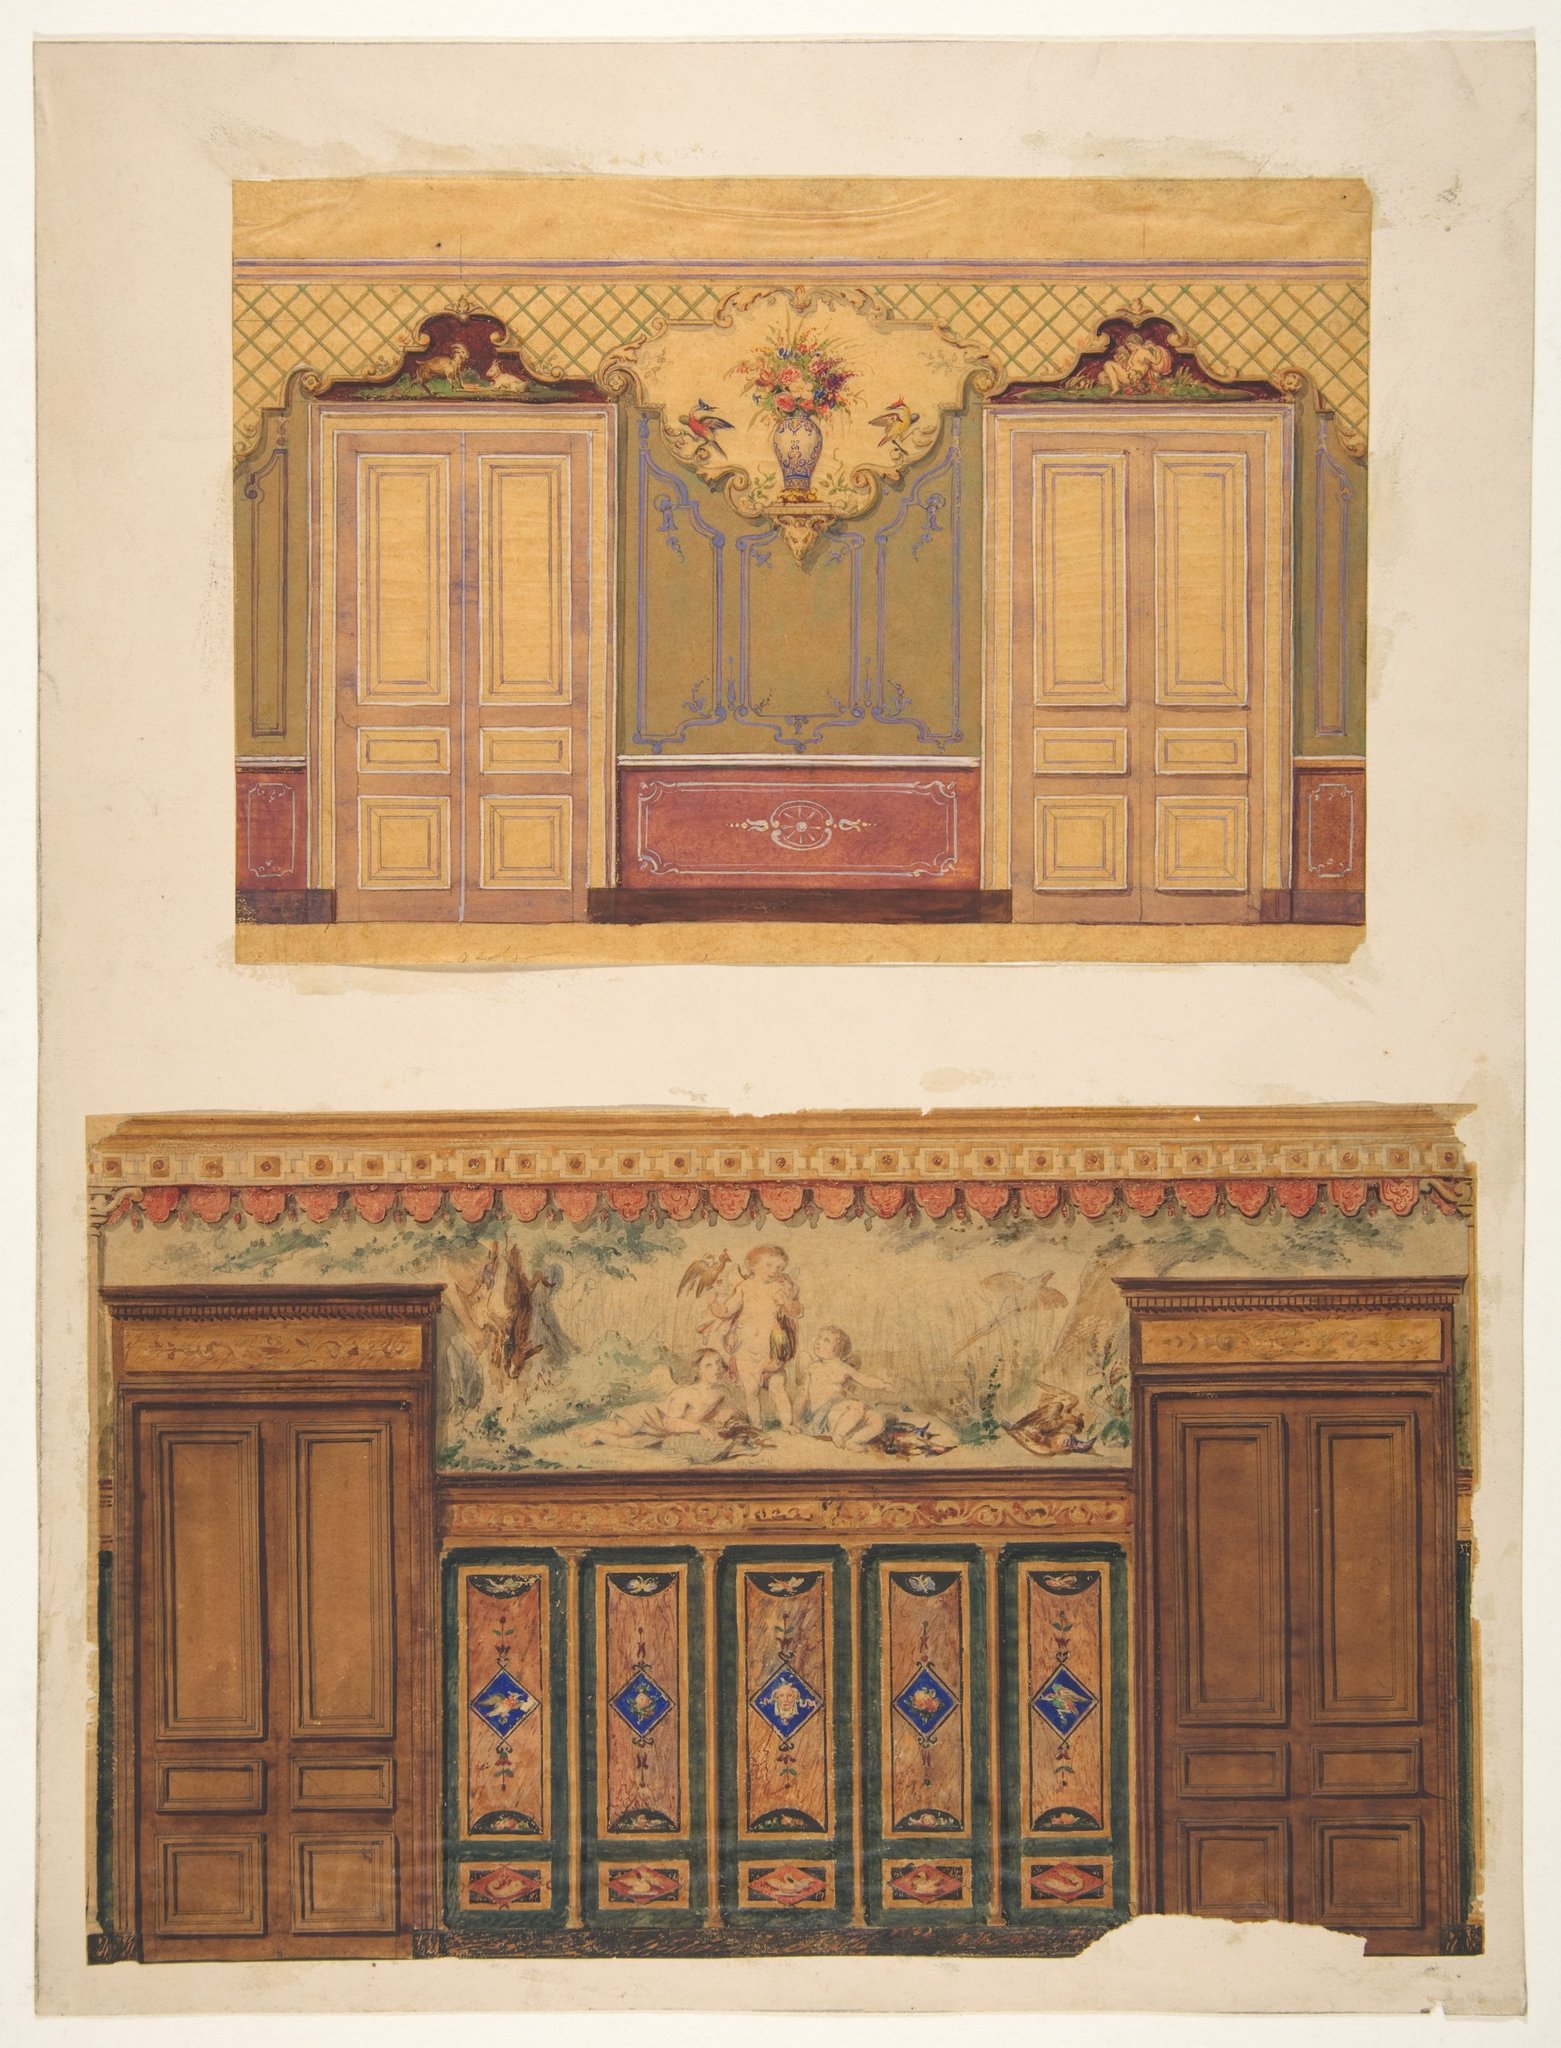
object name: drawing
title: Two Designs for the decoration of walls pierced by pairs of double doors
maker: jules-edmond-charles lachaise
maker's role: artist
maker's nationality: french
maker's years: 1897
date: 1830-1897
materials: graphite, paper, watercolor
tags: birds,doors,flowers